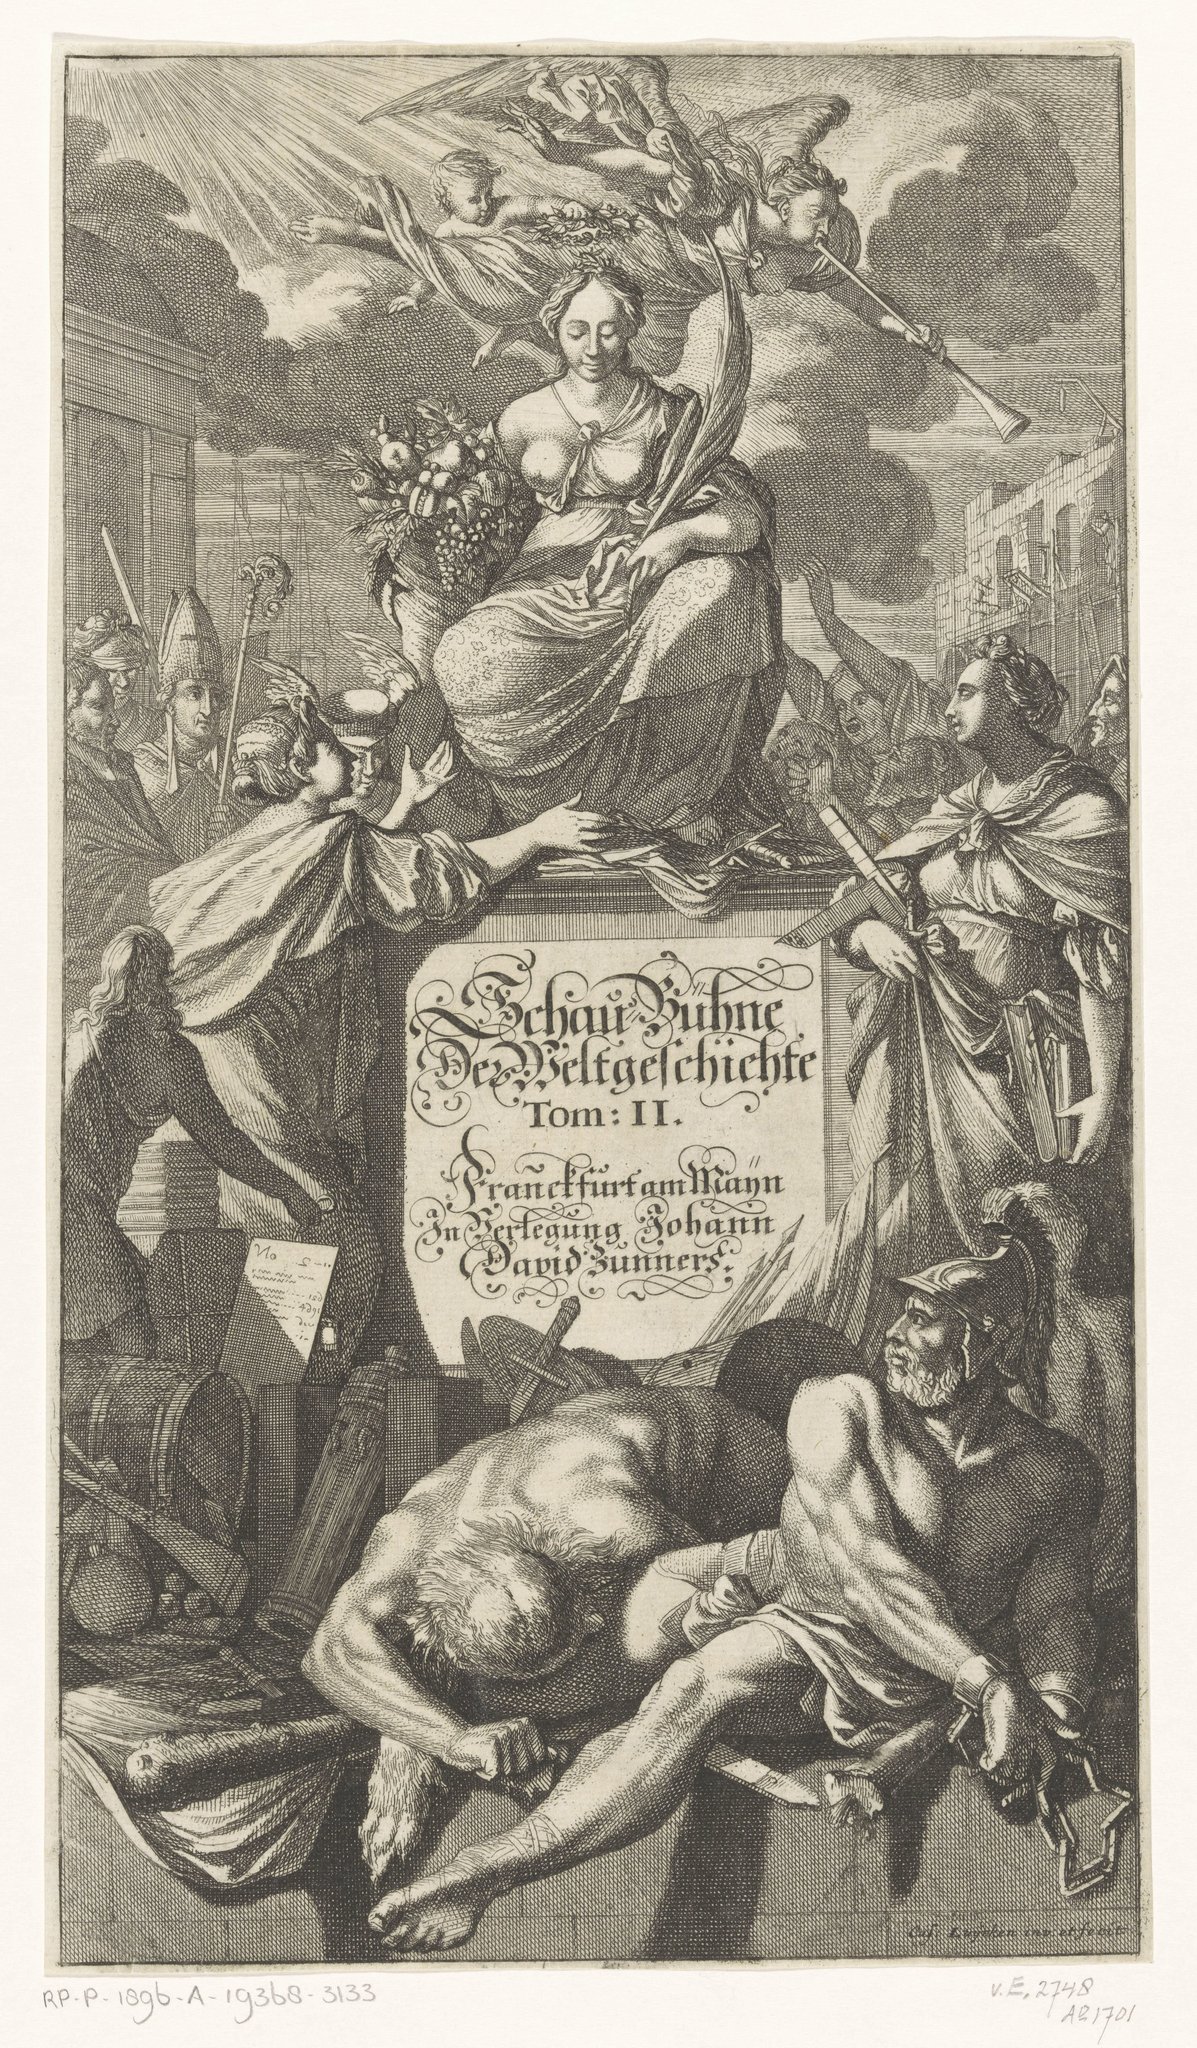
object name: titelblad, titelpagina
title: Schau-Bühnue der Weltgeschichte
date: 1701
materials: paper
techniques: engraving, etching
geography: frankfurt am main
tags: 'cornucopia', horn of plenty, symbolic representations, allegories and emblems ~ science, 'scientia'; 'scienza', 'studio' (ripa), abundance; 'abondanza', 'abondanza maritima' (ripa), fame; 'fama', 'fama buona', 'fama chiara' (ripa)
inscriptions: collector's mark: Lugt 2228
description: De personificatie Overvloed, door een engel gekroond met een laurierkrans, zit op een voetstuk. Ze heeft de hoorn des overvloeds in haar handen. Het voetstuk draagt de Duitse titel van het boekwerk. Boven Overvloed vliegt Faam, blazend op een bazuin. Rondom haar staan verschillende historische personages en personificaties, onder wie Wetenschap (rechts). Voor het voetstuk liggen een gevangene en gesneuvelde.